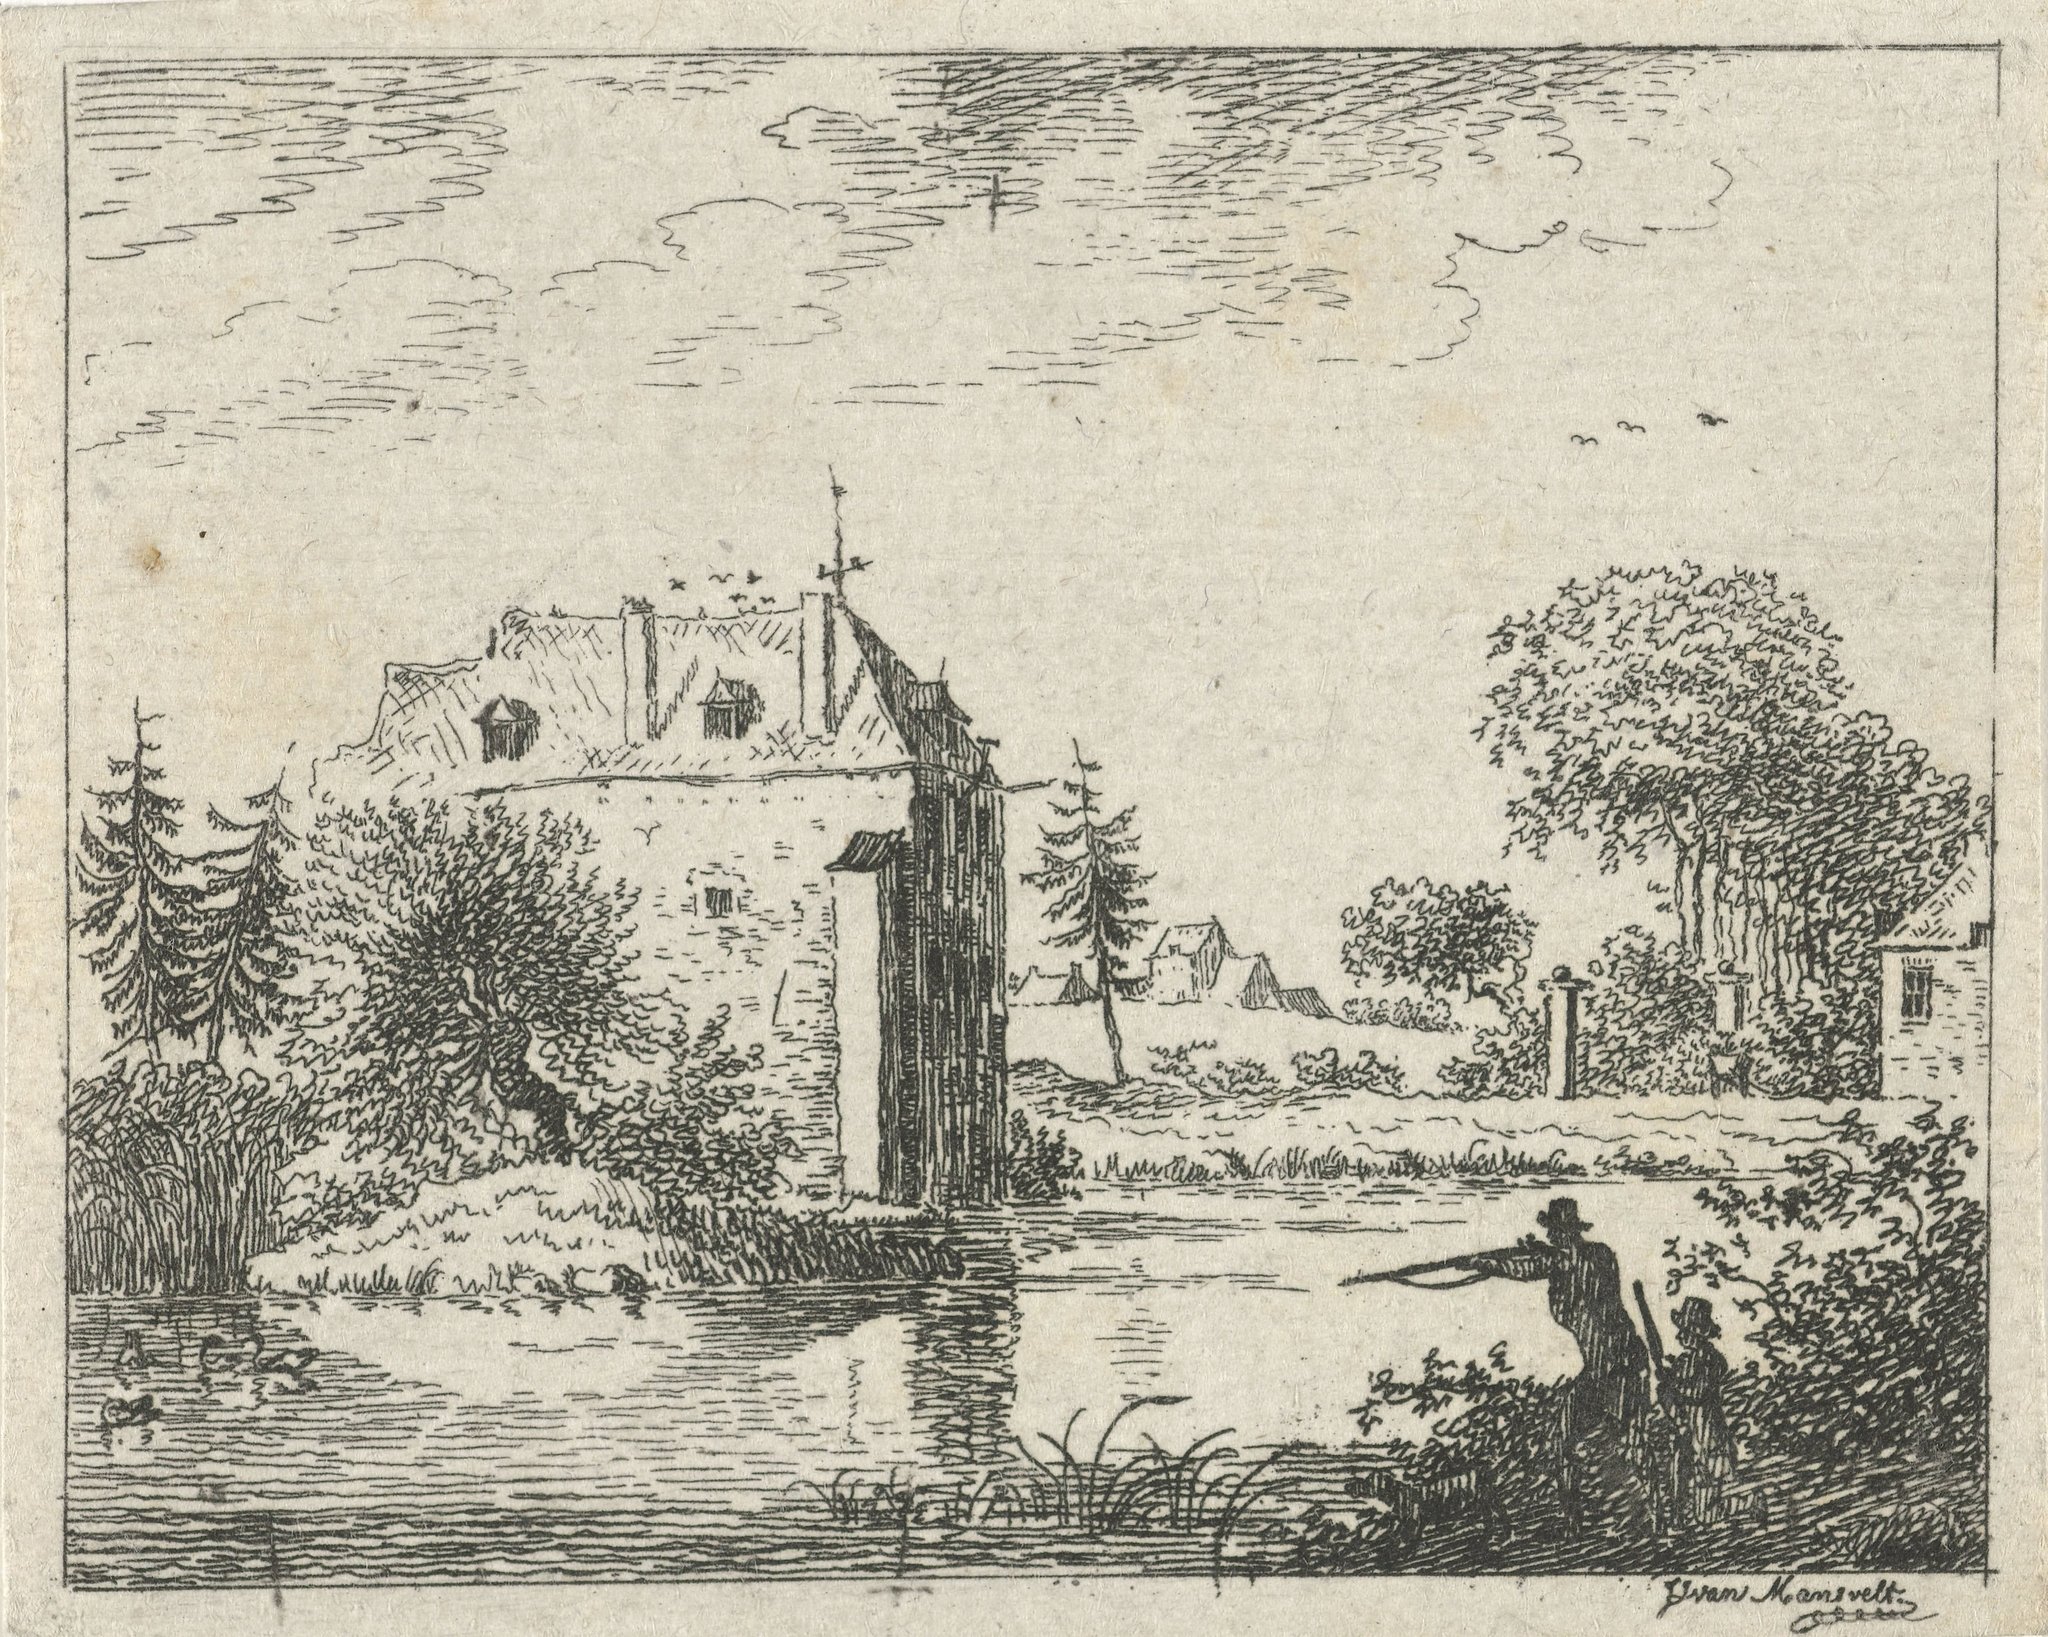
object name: print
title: Versterkt huis aan de waterkant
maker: jan izaak van mansvelt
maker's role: print maker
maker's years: 1761-1802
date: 1771-1802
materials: paper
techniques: etching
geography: netherlands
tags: castle, hunter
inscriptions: collector's mark: Lugt 2228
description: Een versterkt huis aan de kant van een meer. Rechts op de voorgrond een staande en een geknielde jager die op eenden schieten.